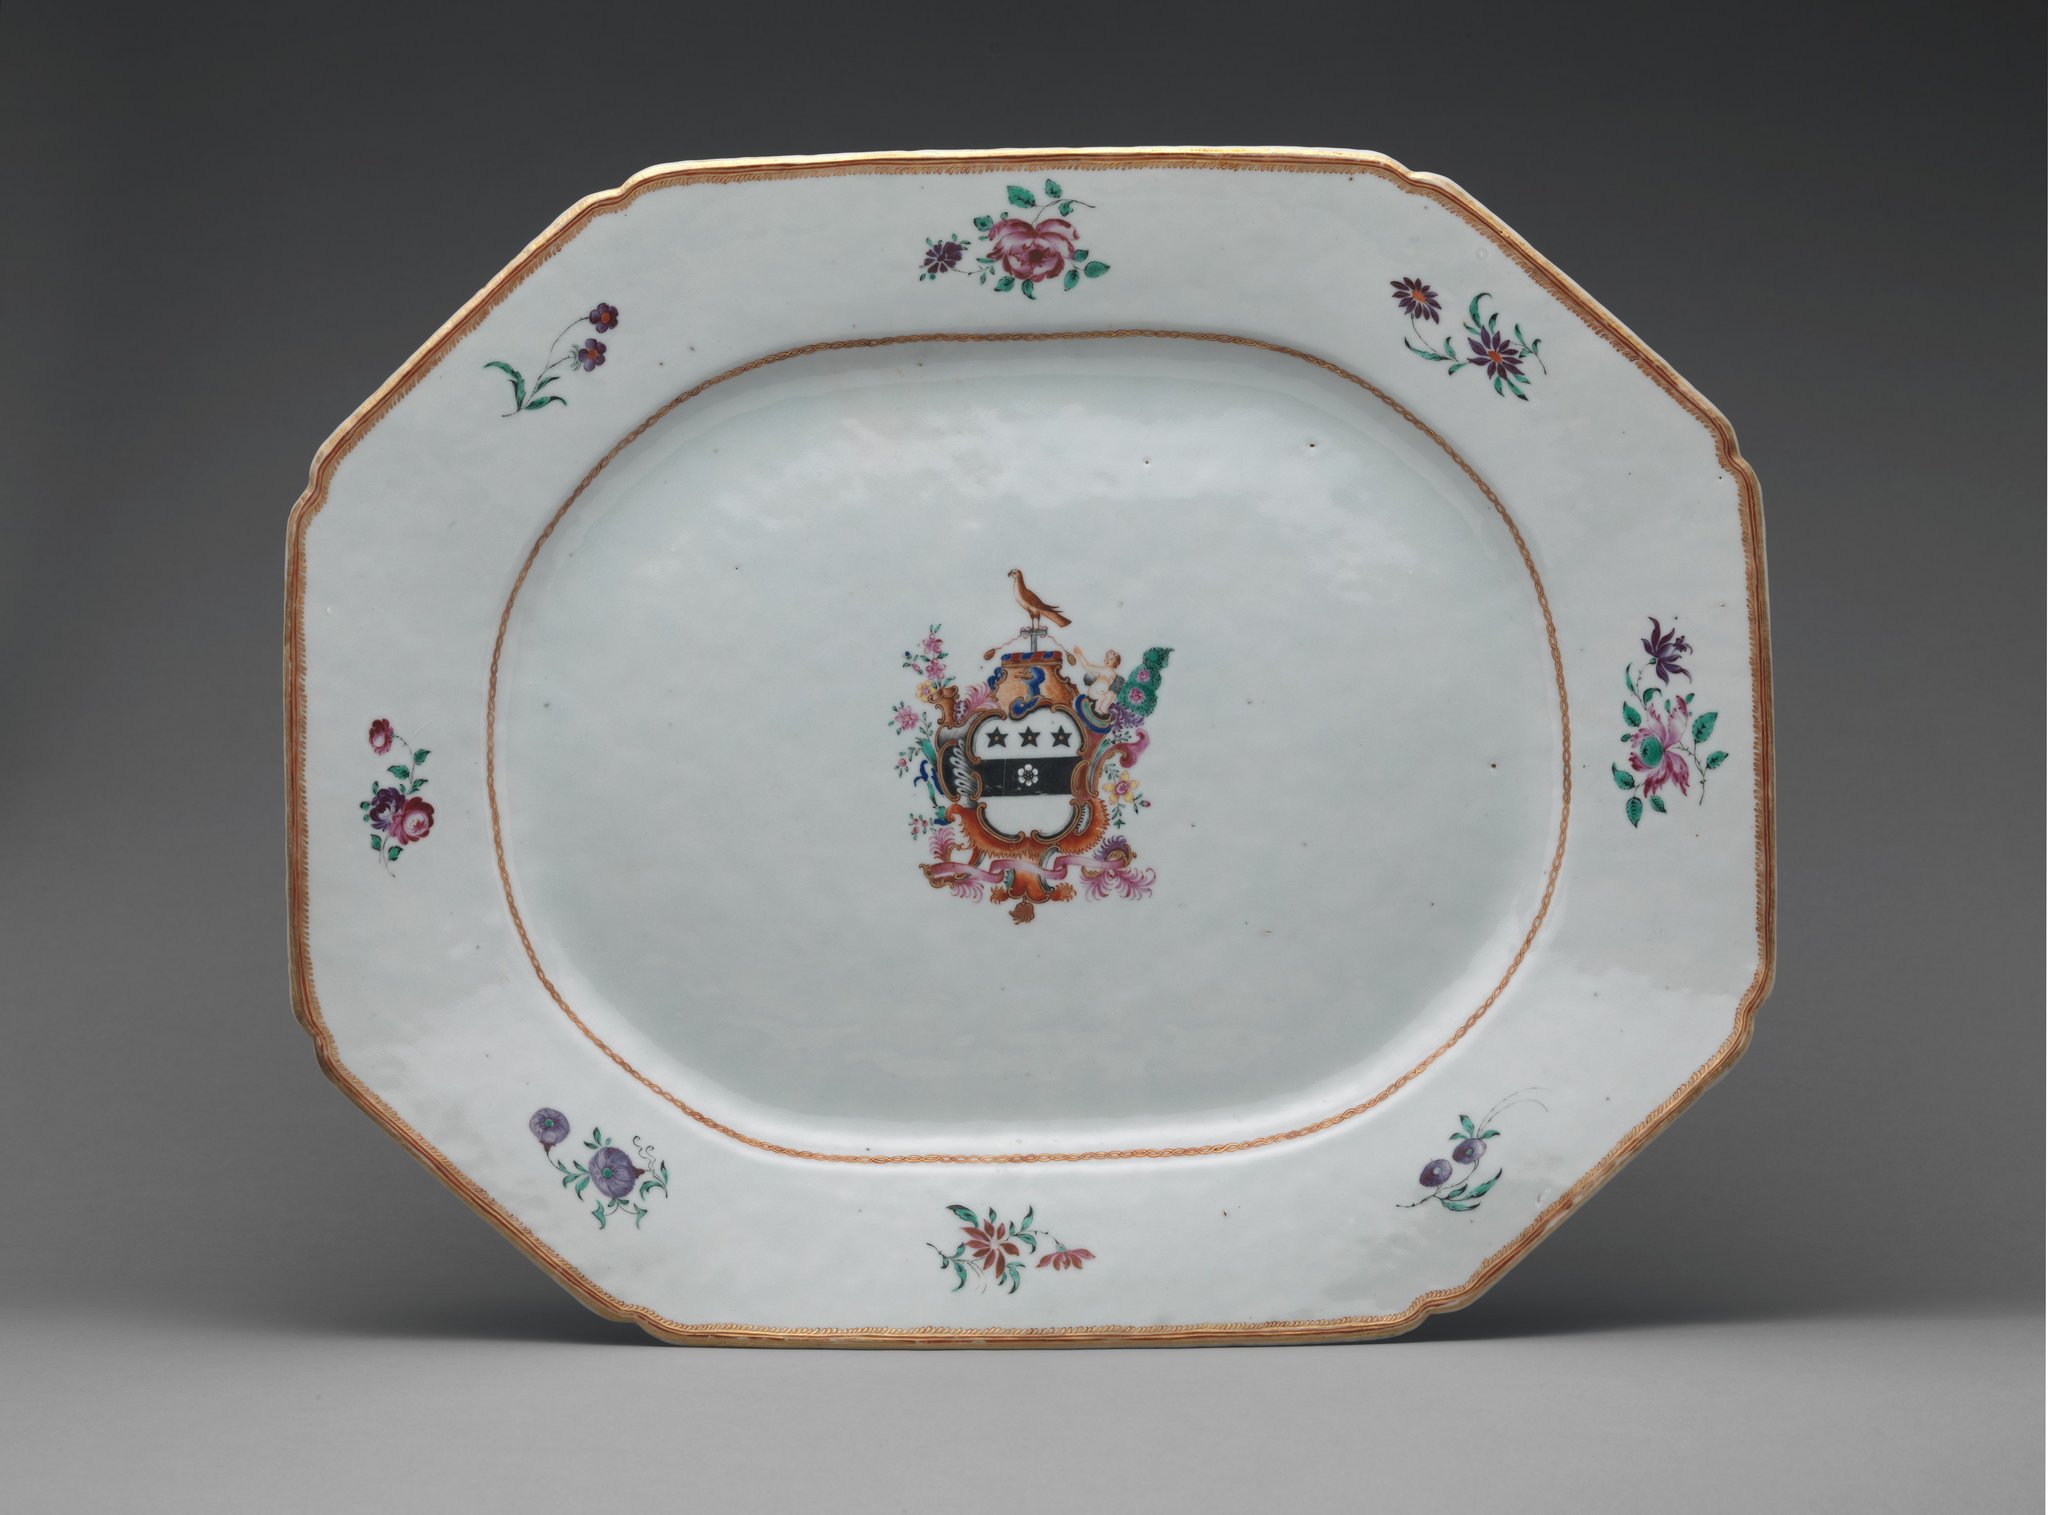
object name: platter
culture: chinese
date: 1785-1790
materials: porcelain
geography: china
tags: birds,flowers,coat of arms